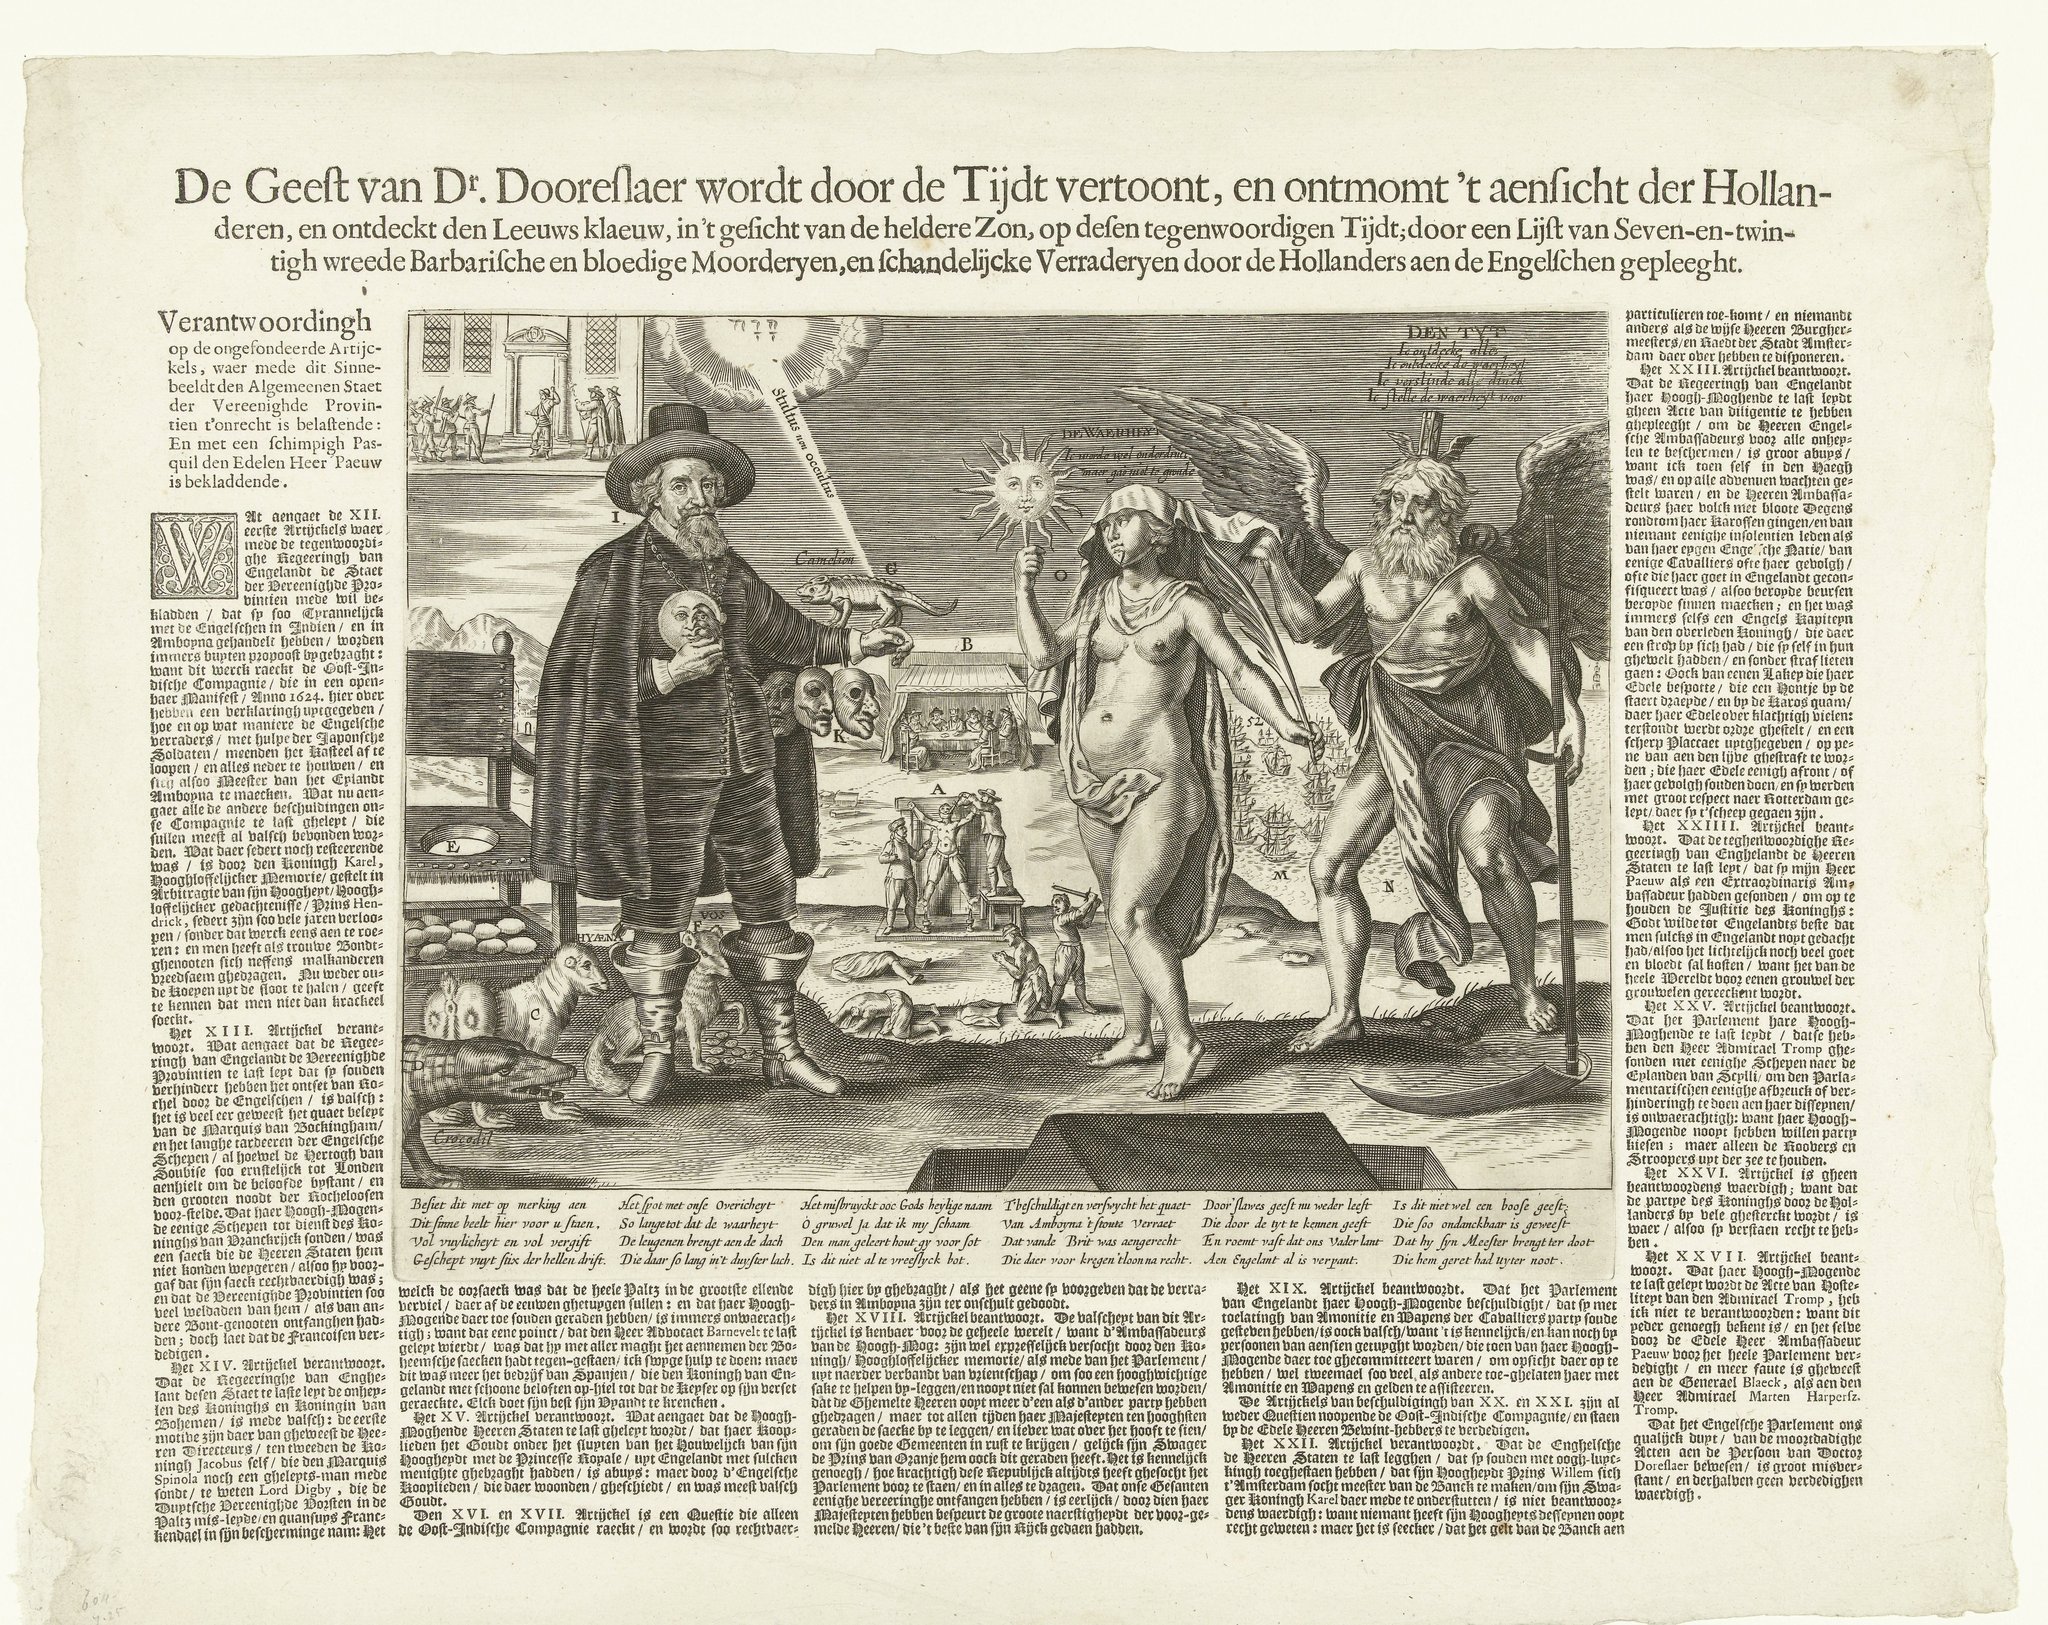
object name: propagandaprent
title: Kopie van een Engelse spotprent op de Hollanders, 1652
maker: Anonymous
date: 1652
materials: paper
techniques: engraving, letterpress printing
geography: northern netherlands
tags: amsterdam, the hague, politician, adriaen pauw (1585-1653), time revealing truth; time carrying truth aloft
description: Kopie van een Engelse spotprent op de Hollanders uit 1652, ten tijde van de Eerste Engelse Oorlog. Isaäc Doreslaer staande tegenover de naakte Waarheid en Vader Tijd. Op zijn arm een kameleon en maskers. Op de achtergrond wreedheden begaan door de Hollanders tegen de Engelsen. Met onderschrift van 6 verzen van 4 regels in het Nederlands. Op het blad om de voorstelling een lijst van de wreedheden van de Hollanders genummerd artikel XII - XXVII. In de oorspronkelijke voorstelling wordt de centrale figuur de Nederlandse ambassadeur Paulus van der Perre verklaard als de geest van de vermoorde Doreslaer. In de tekst bij de prent wordt de figuur geïdentificeerd als Adriaen Pauw. De kleine scène linksboven toont de moord gepleegd op Isaäc Dorislaer door een groep gemaskerde mannen in herberg De Zwaan op de Plaats te 's-Gravenhage, 12 mei 1649.